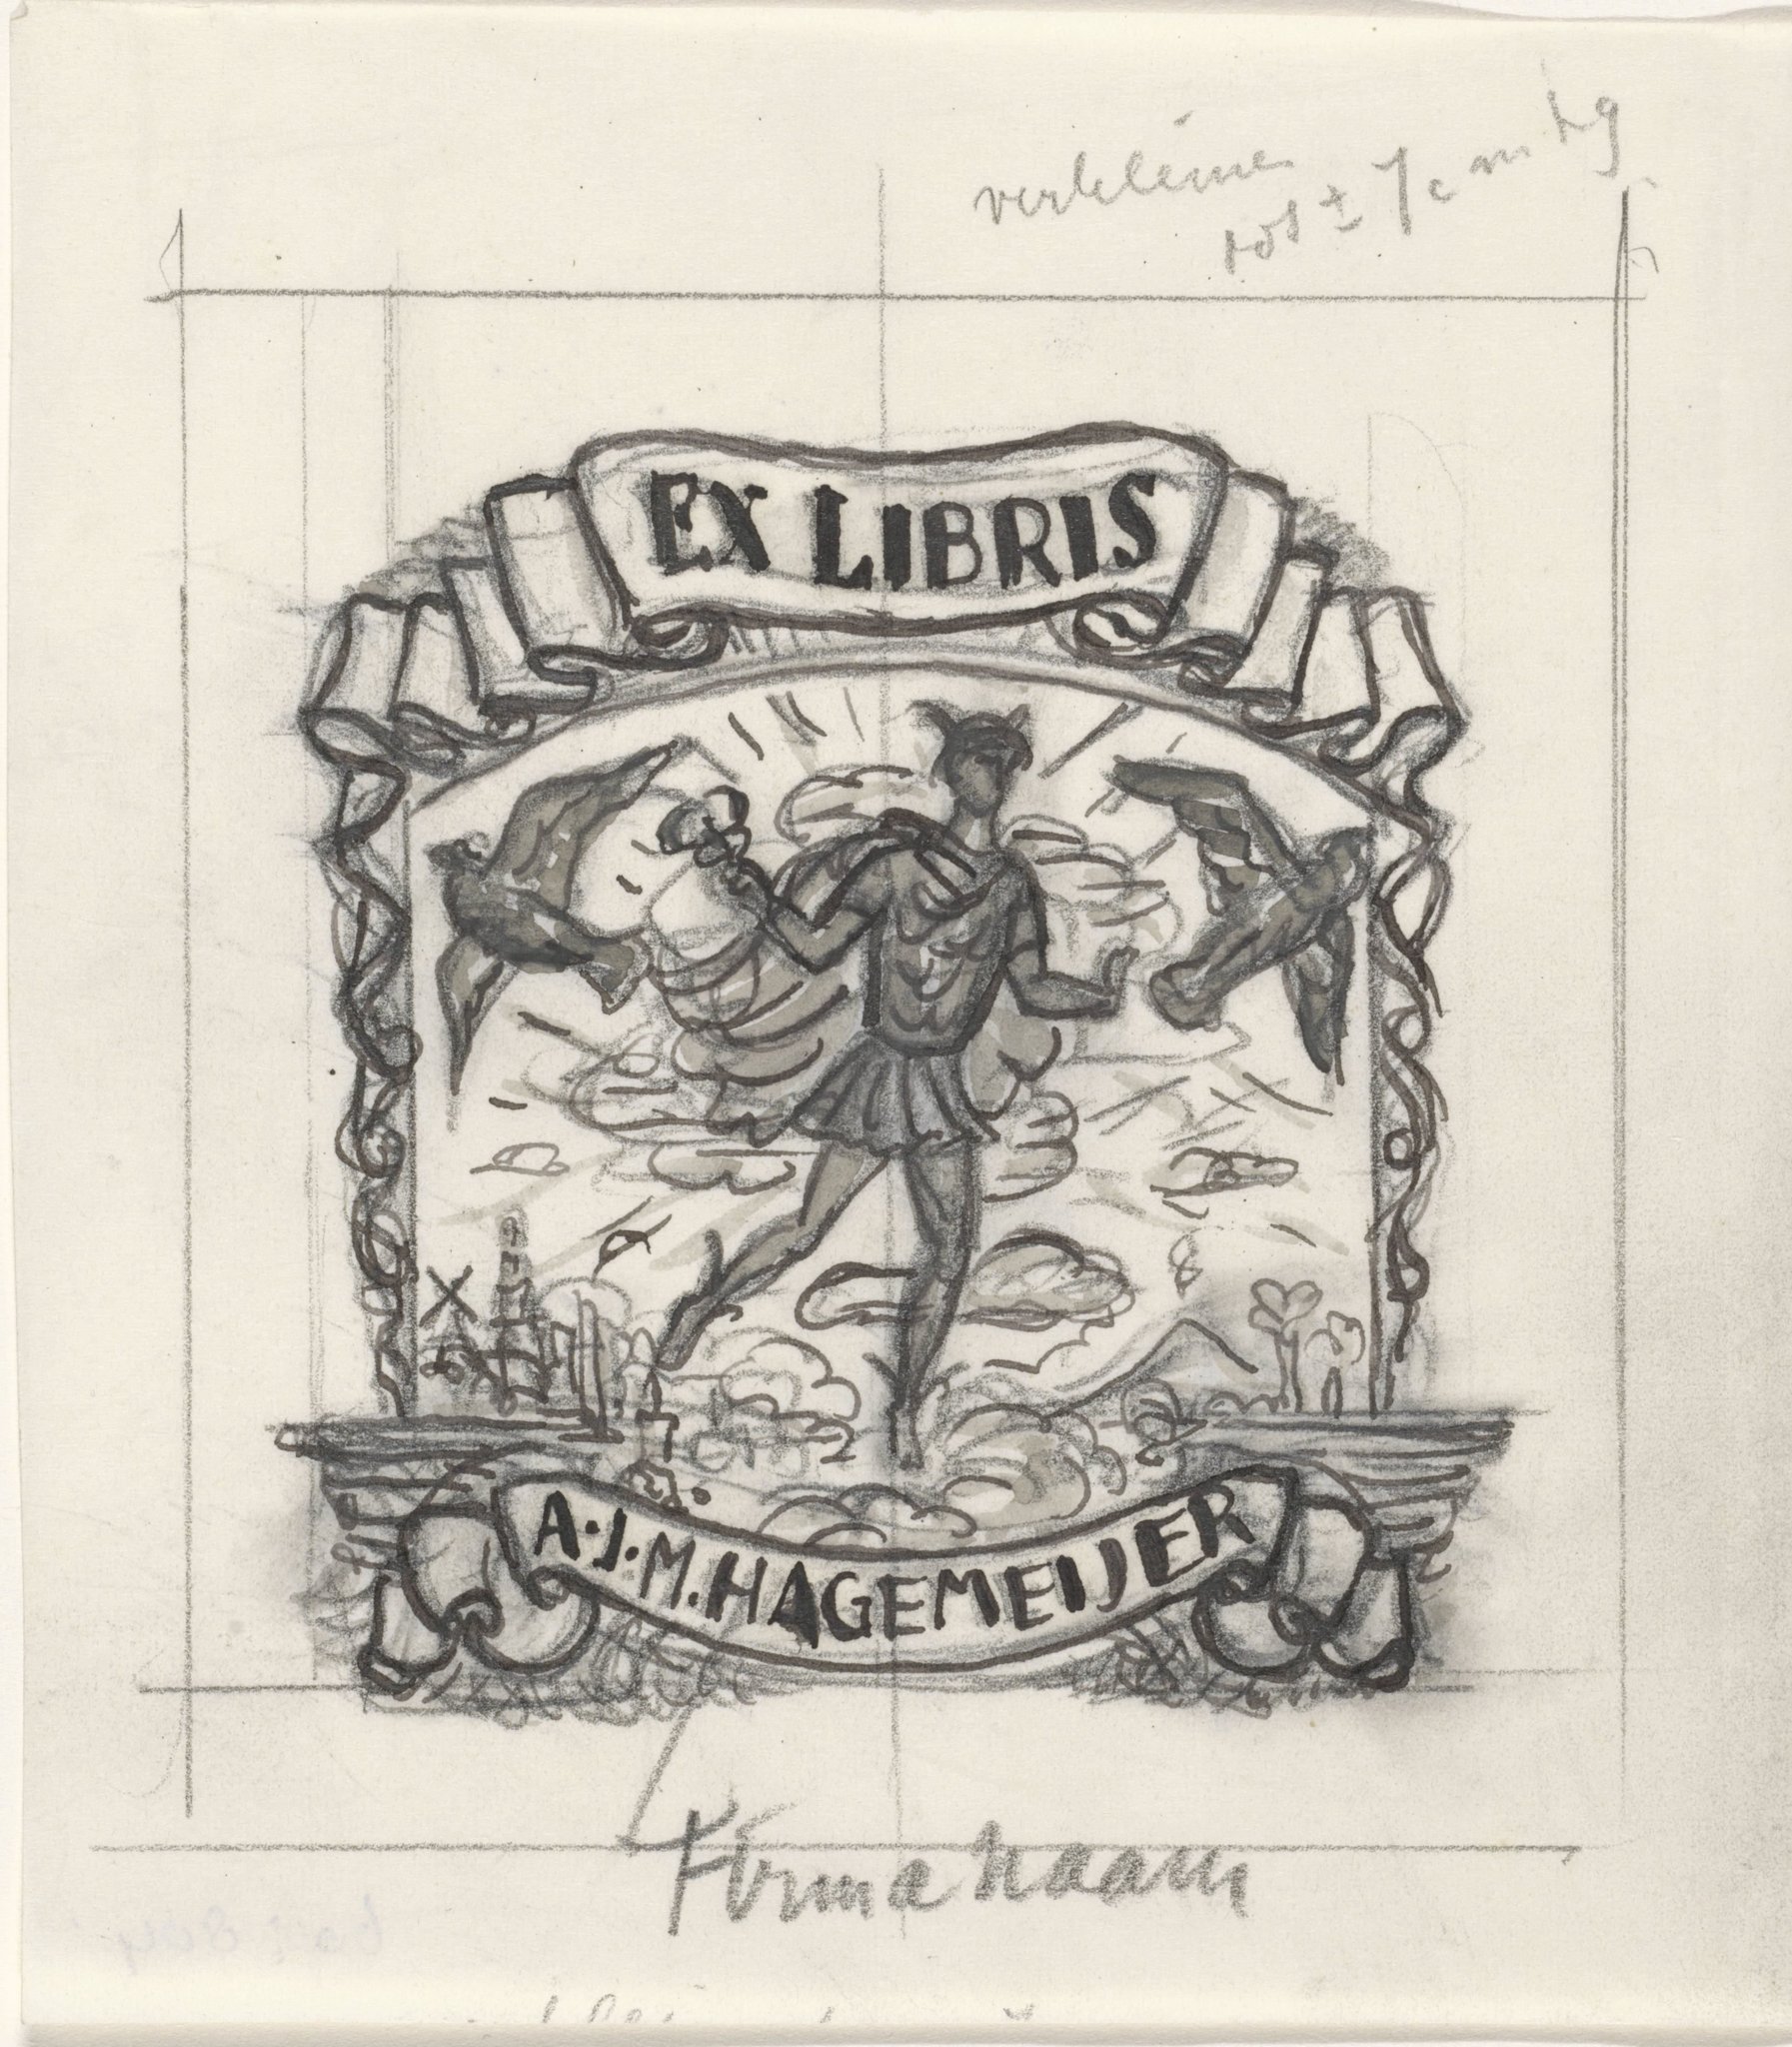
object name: design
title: Ontwerp voor een ex libris van Antonius Johannes Maria Hagemeijer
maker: leo gestel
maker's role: draughtsman, print maker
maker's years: 1881-1941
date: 1891-1941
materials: ink, pencil, paper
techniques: pen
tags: (story of) mercury (hermes)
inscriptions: collector's mark: Lugt 2228